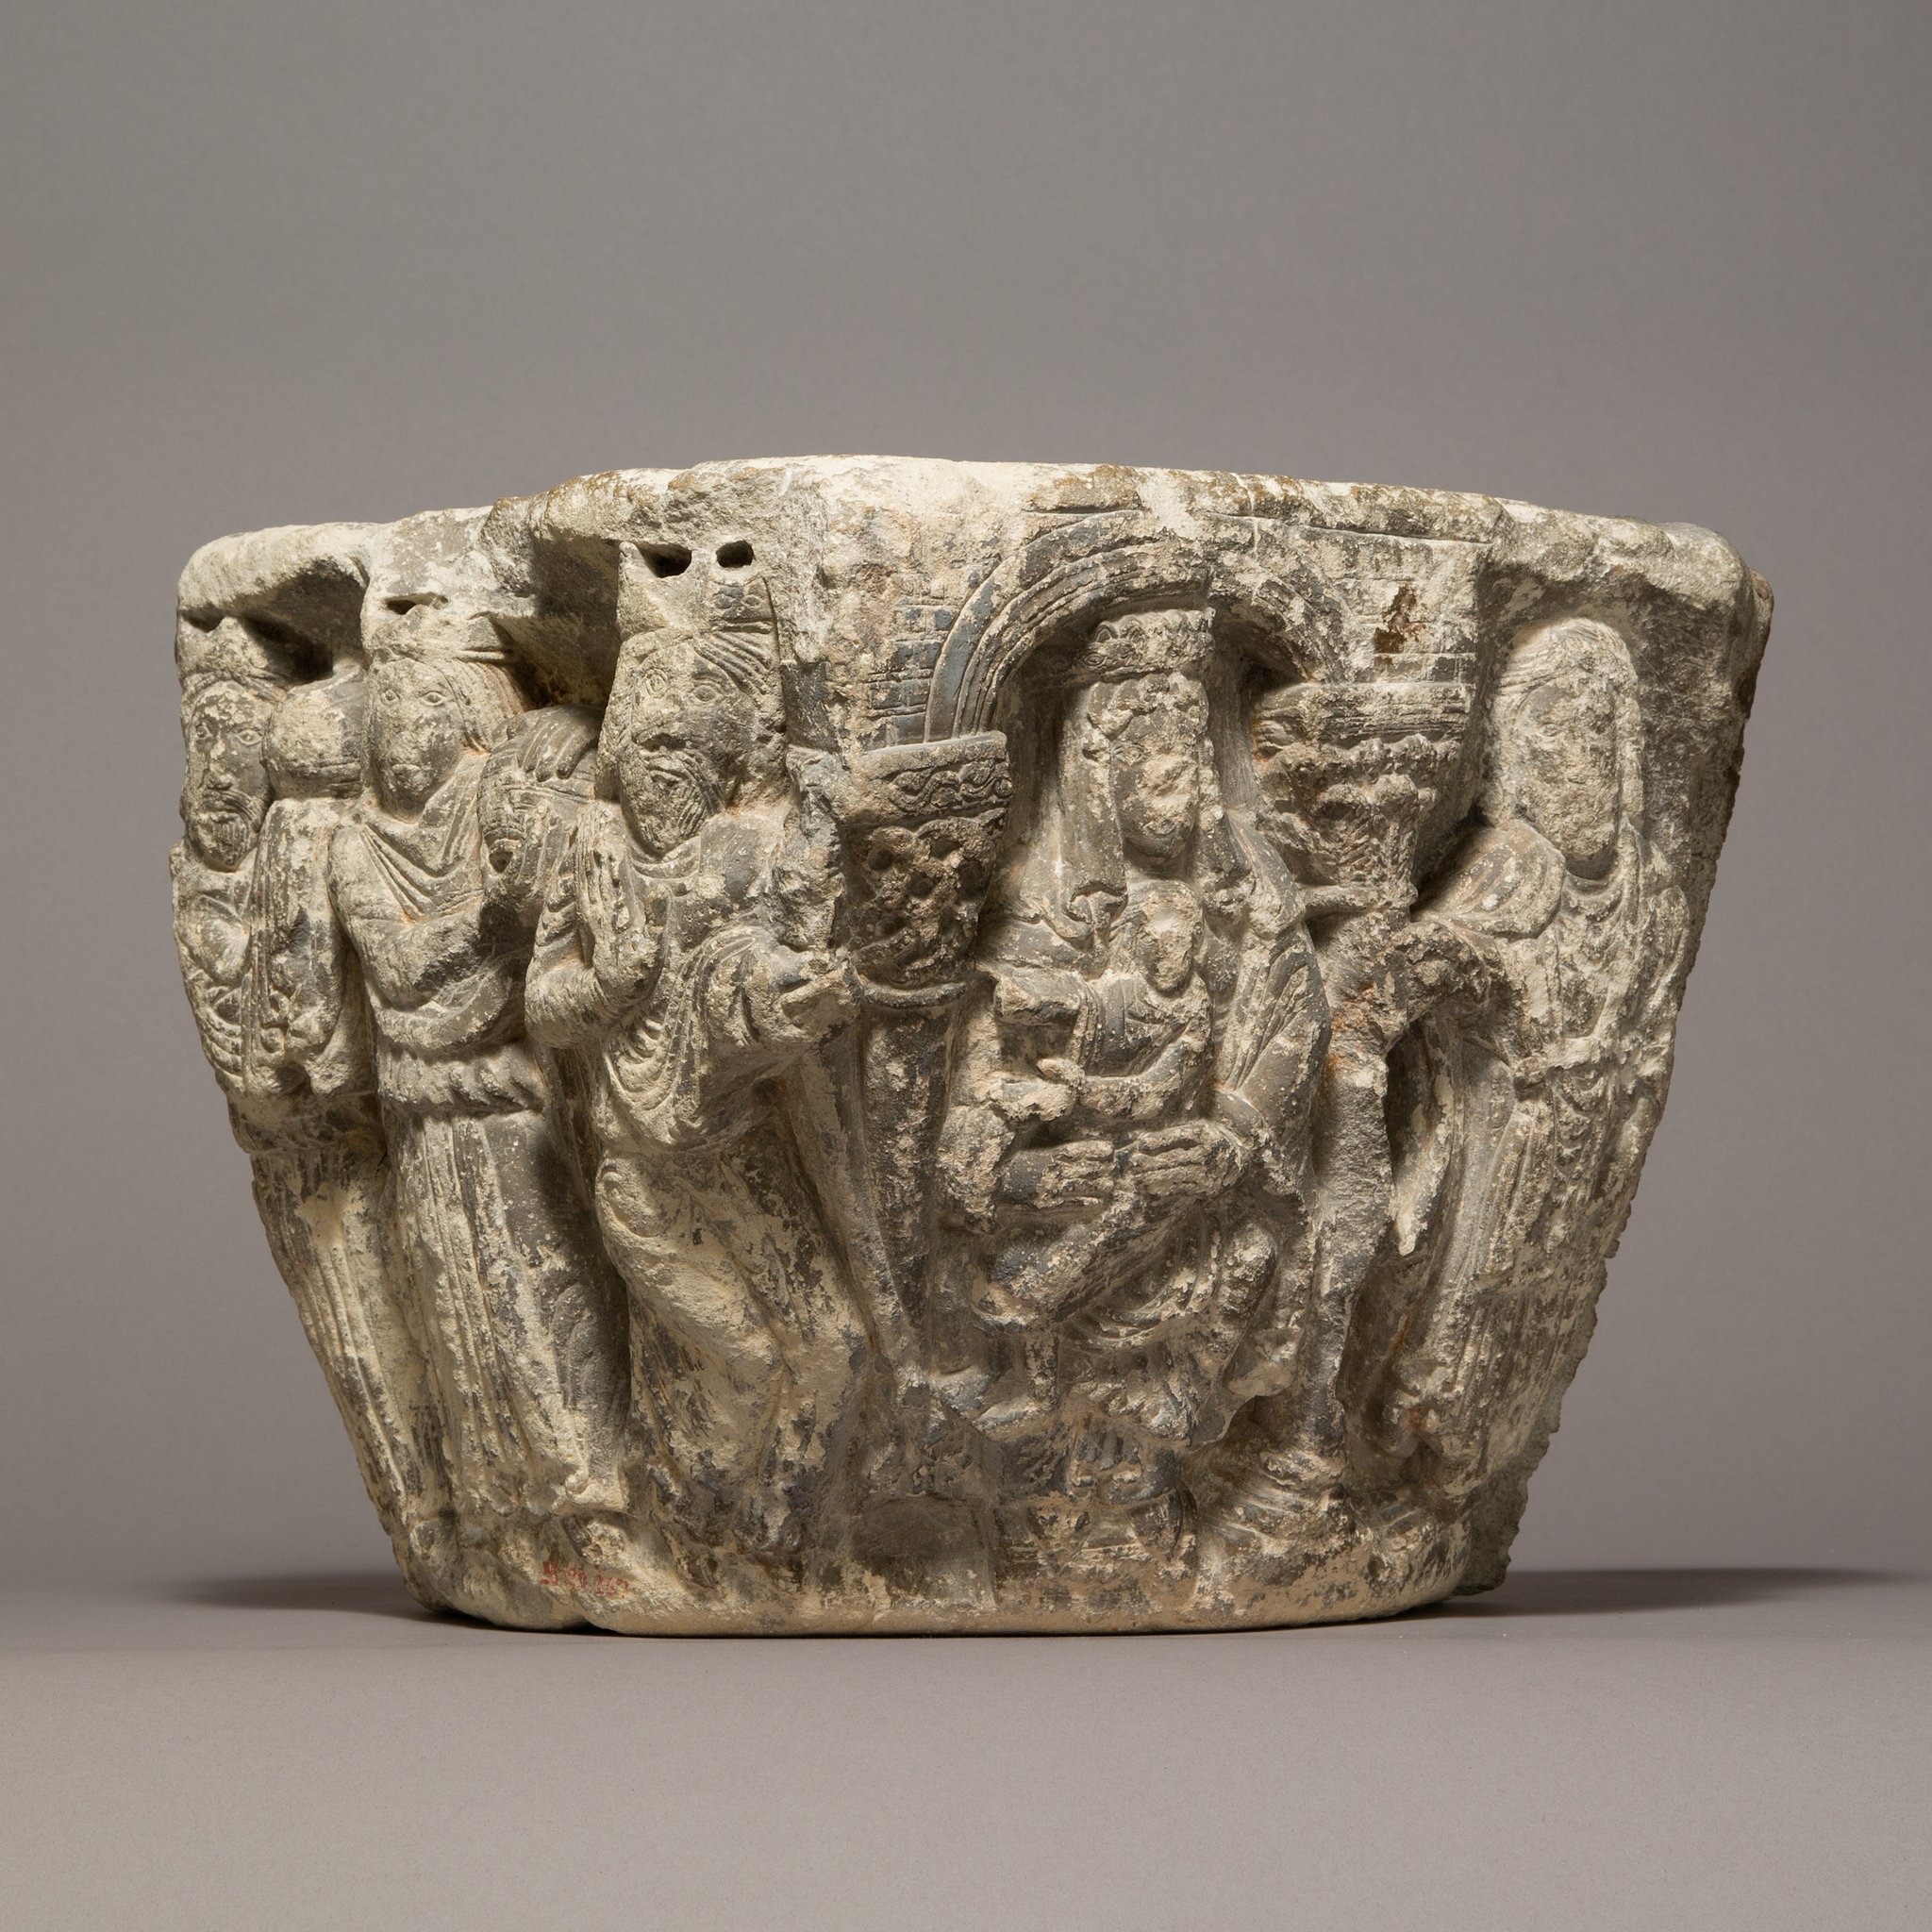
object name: capital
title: Capital with Nativity and Adoration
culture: french or spanish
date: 1101-1200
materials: stone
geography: spain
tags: adoration of the magi,nativity